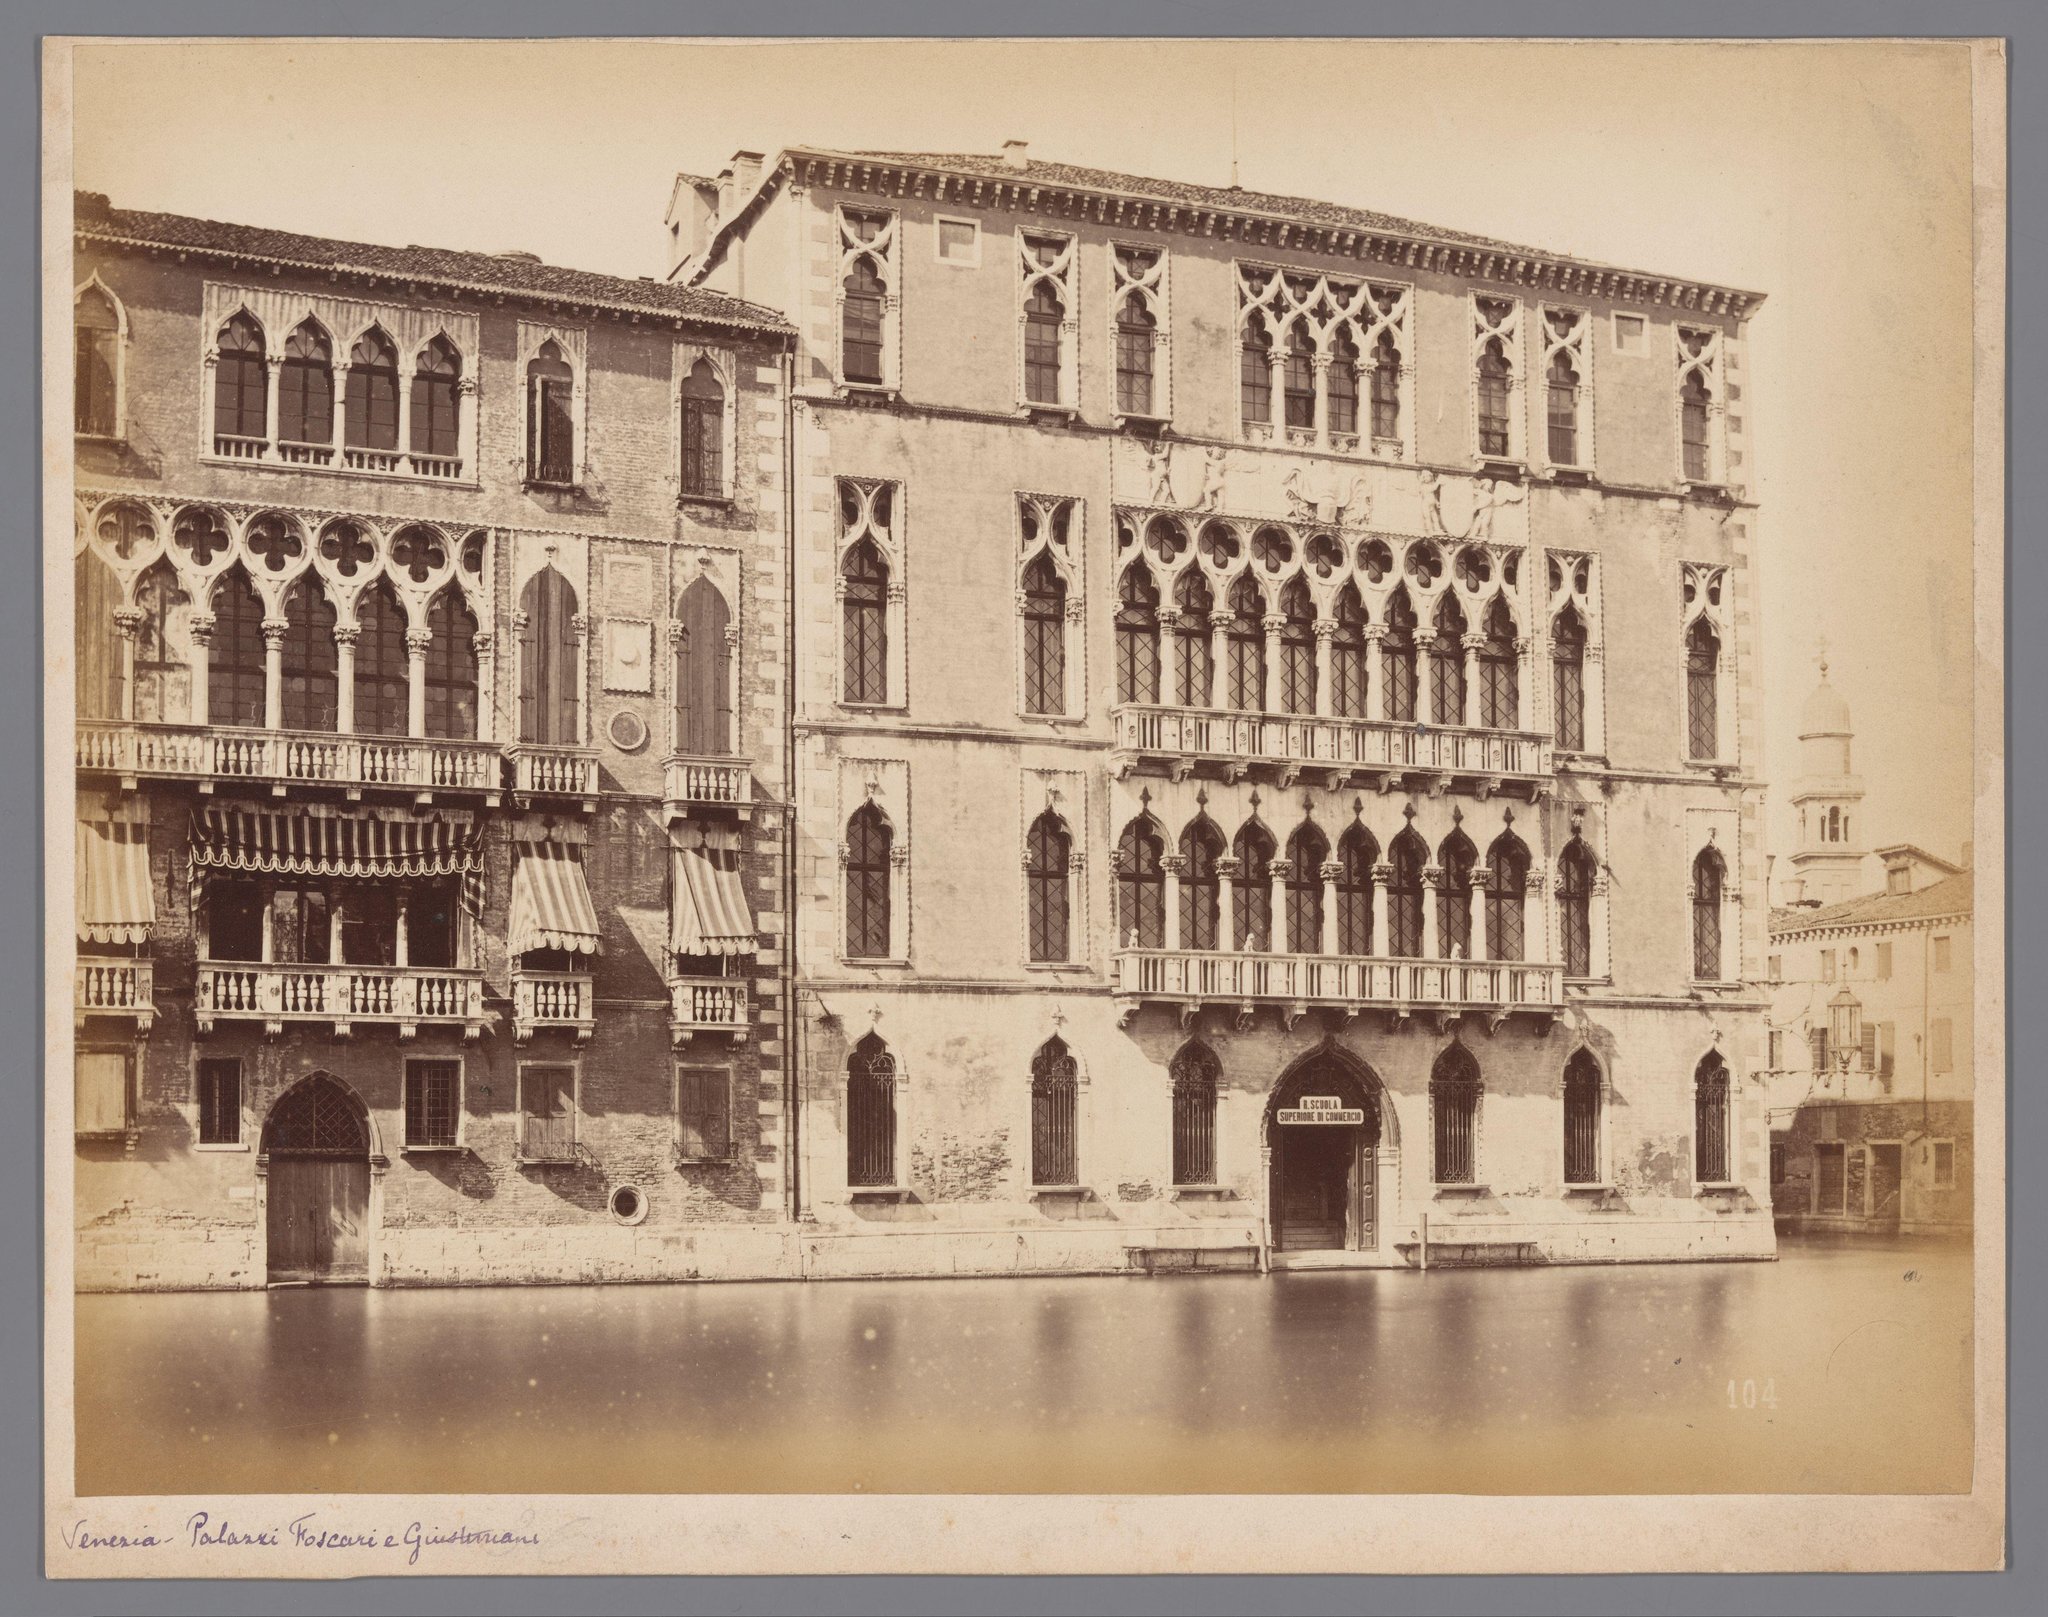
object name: photograph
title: Palazzo Foscari aan het Canal Grande te Venetië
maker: Anonymous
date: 1851-1900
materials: cardboard, paper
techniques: albumen print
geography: venice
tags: exterior ~ representation of a building, hôtel, i.e. small palace in city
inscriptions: number: ‘104’